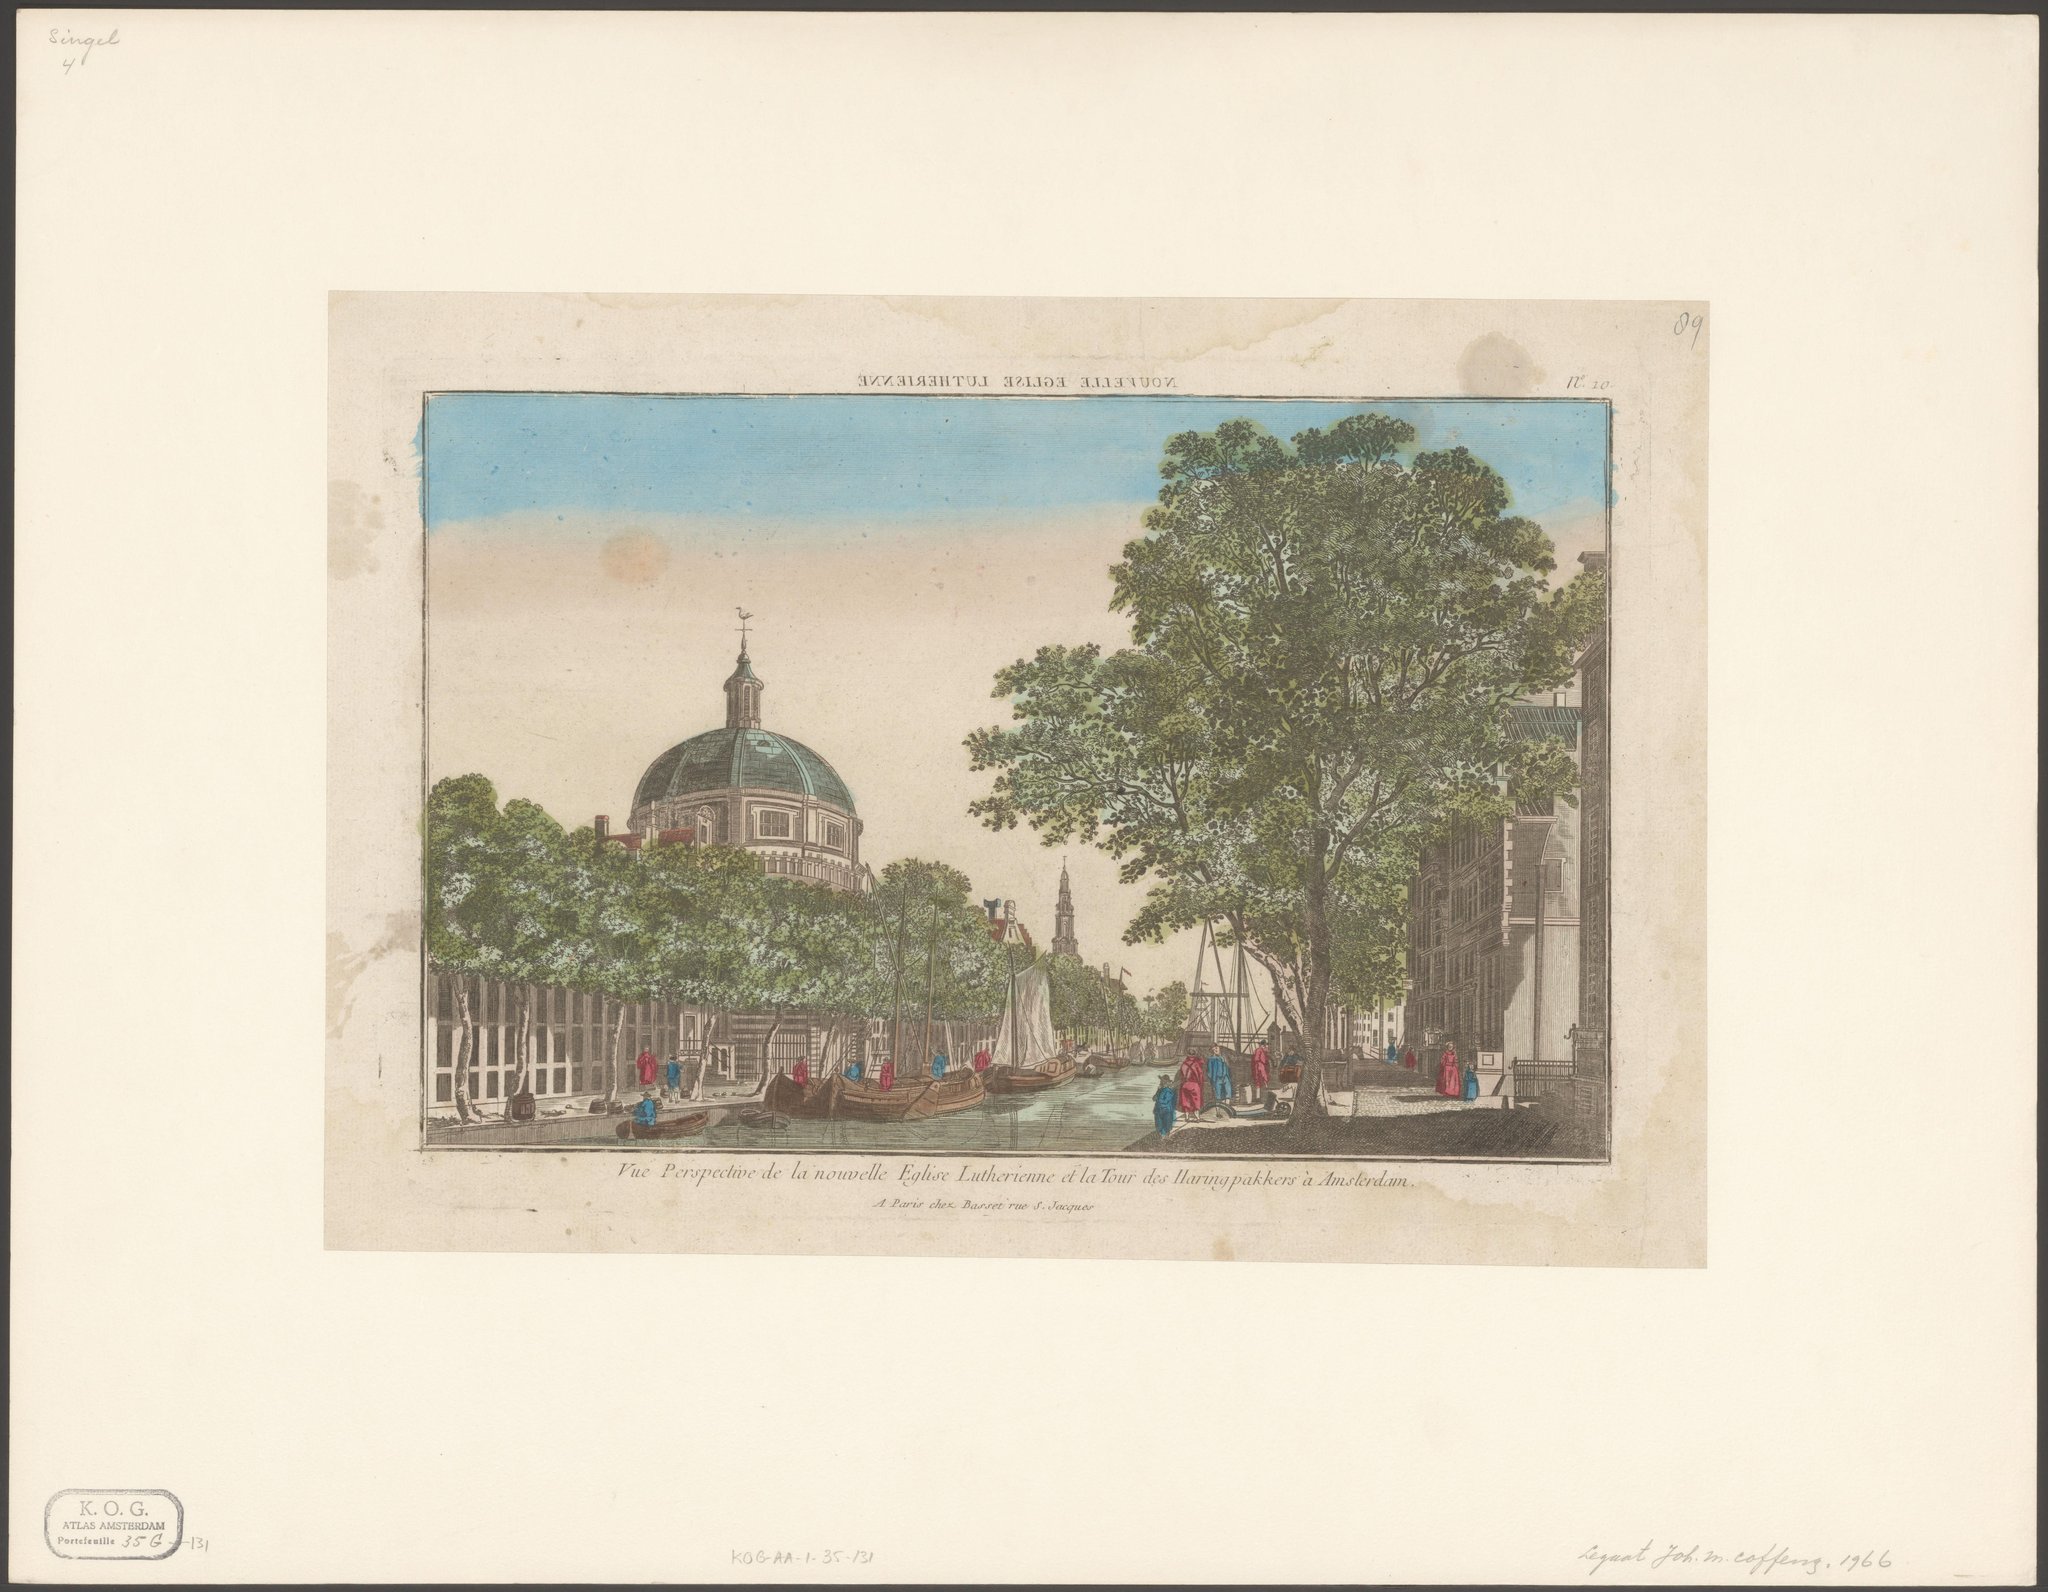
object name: opticaprent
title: Gezicht op de Nieuwe Lutherse Kerk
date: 1749-1785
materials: paper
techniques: engraving, etching, hand coloring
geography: amsterdam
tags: protestant churches and denominations (lutherans), towers ~ fortified city, parts of church exterior and annexes: dome, canals, waters (in city)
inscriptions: collector's mark: ‘35G-131’ Lugt 1641b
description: Rechtsboven genummerd: 10. Onderwerpsrubriek binnen de Atlas Amsterdam: Ev. Lutherse Gemeente: Nieuwe of Ronde Kerk.